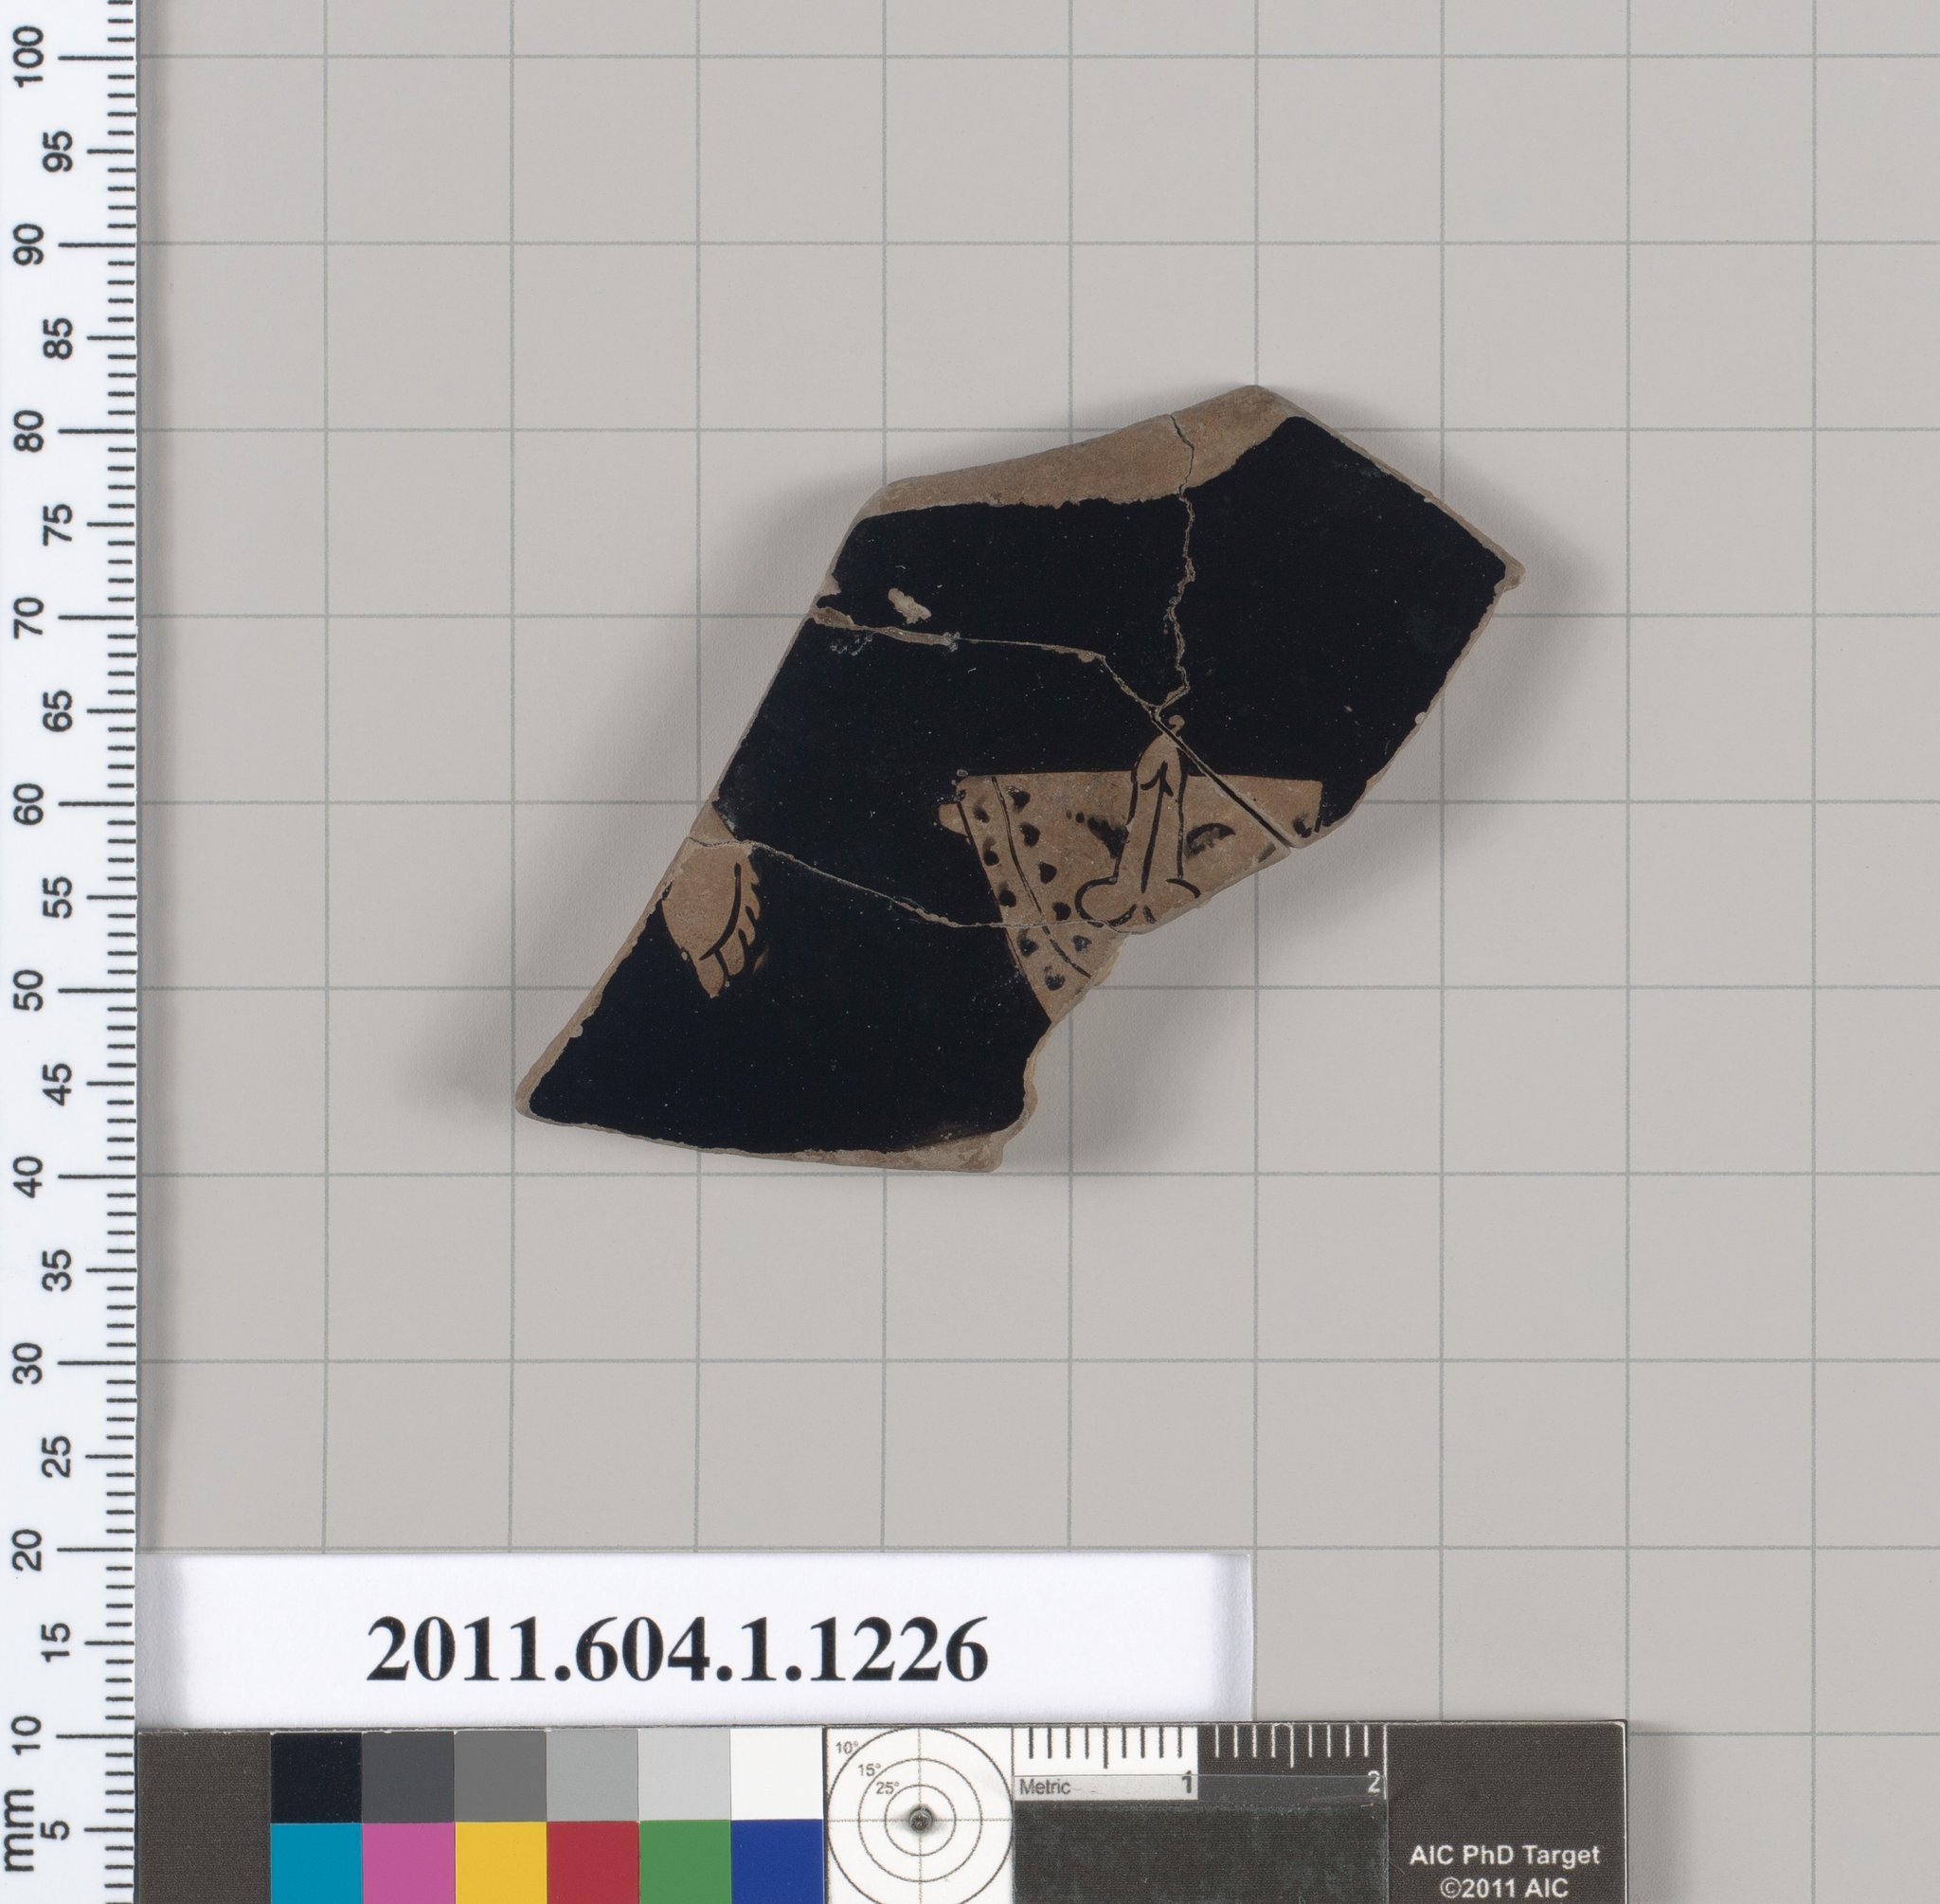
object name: kylix fragment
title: Terracotta fragment of a kylix (drinking cup)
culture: greek, attic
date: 490-480 BCE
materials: terracotta